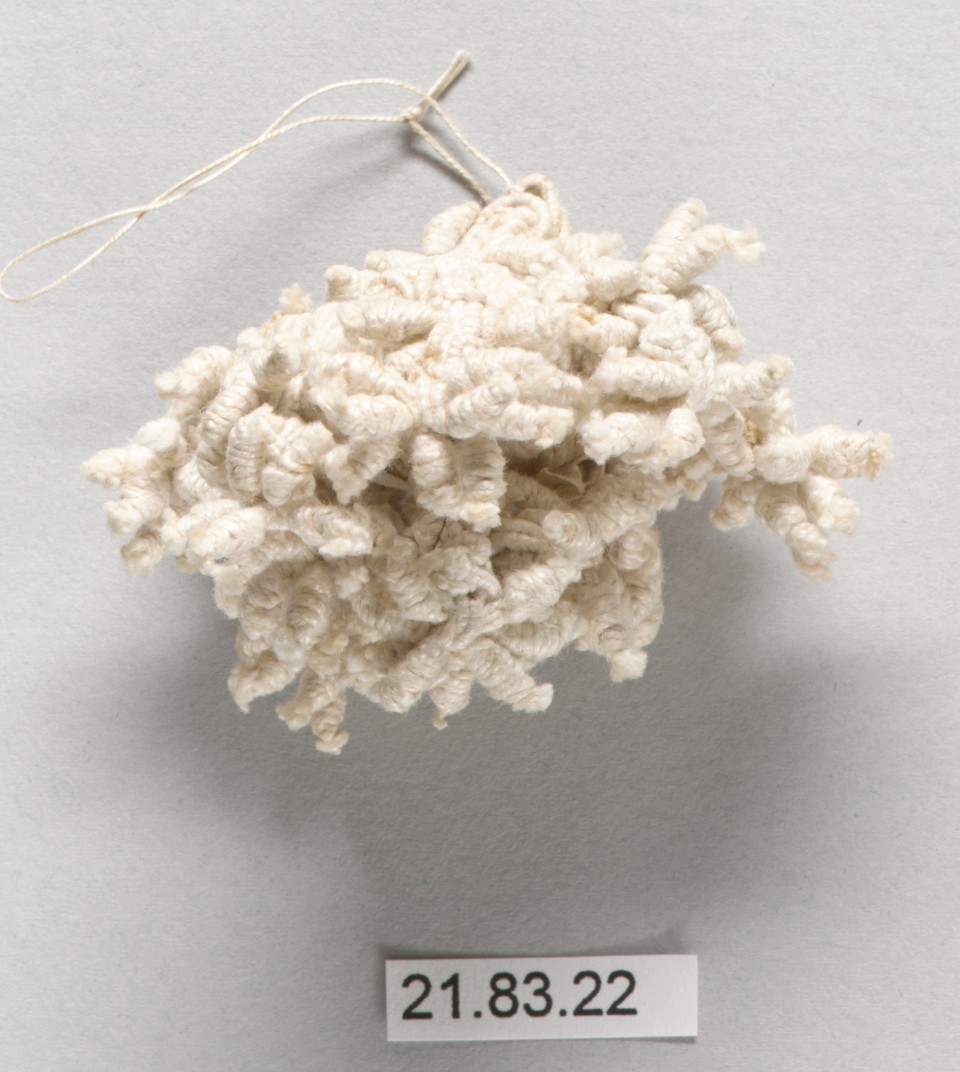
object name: tassel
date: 1601-1700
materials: linen